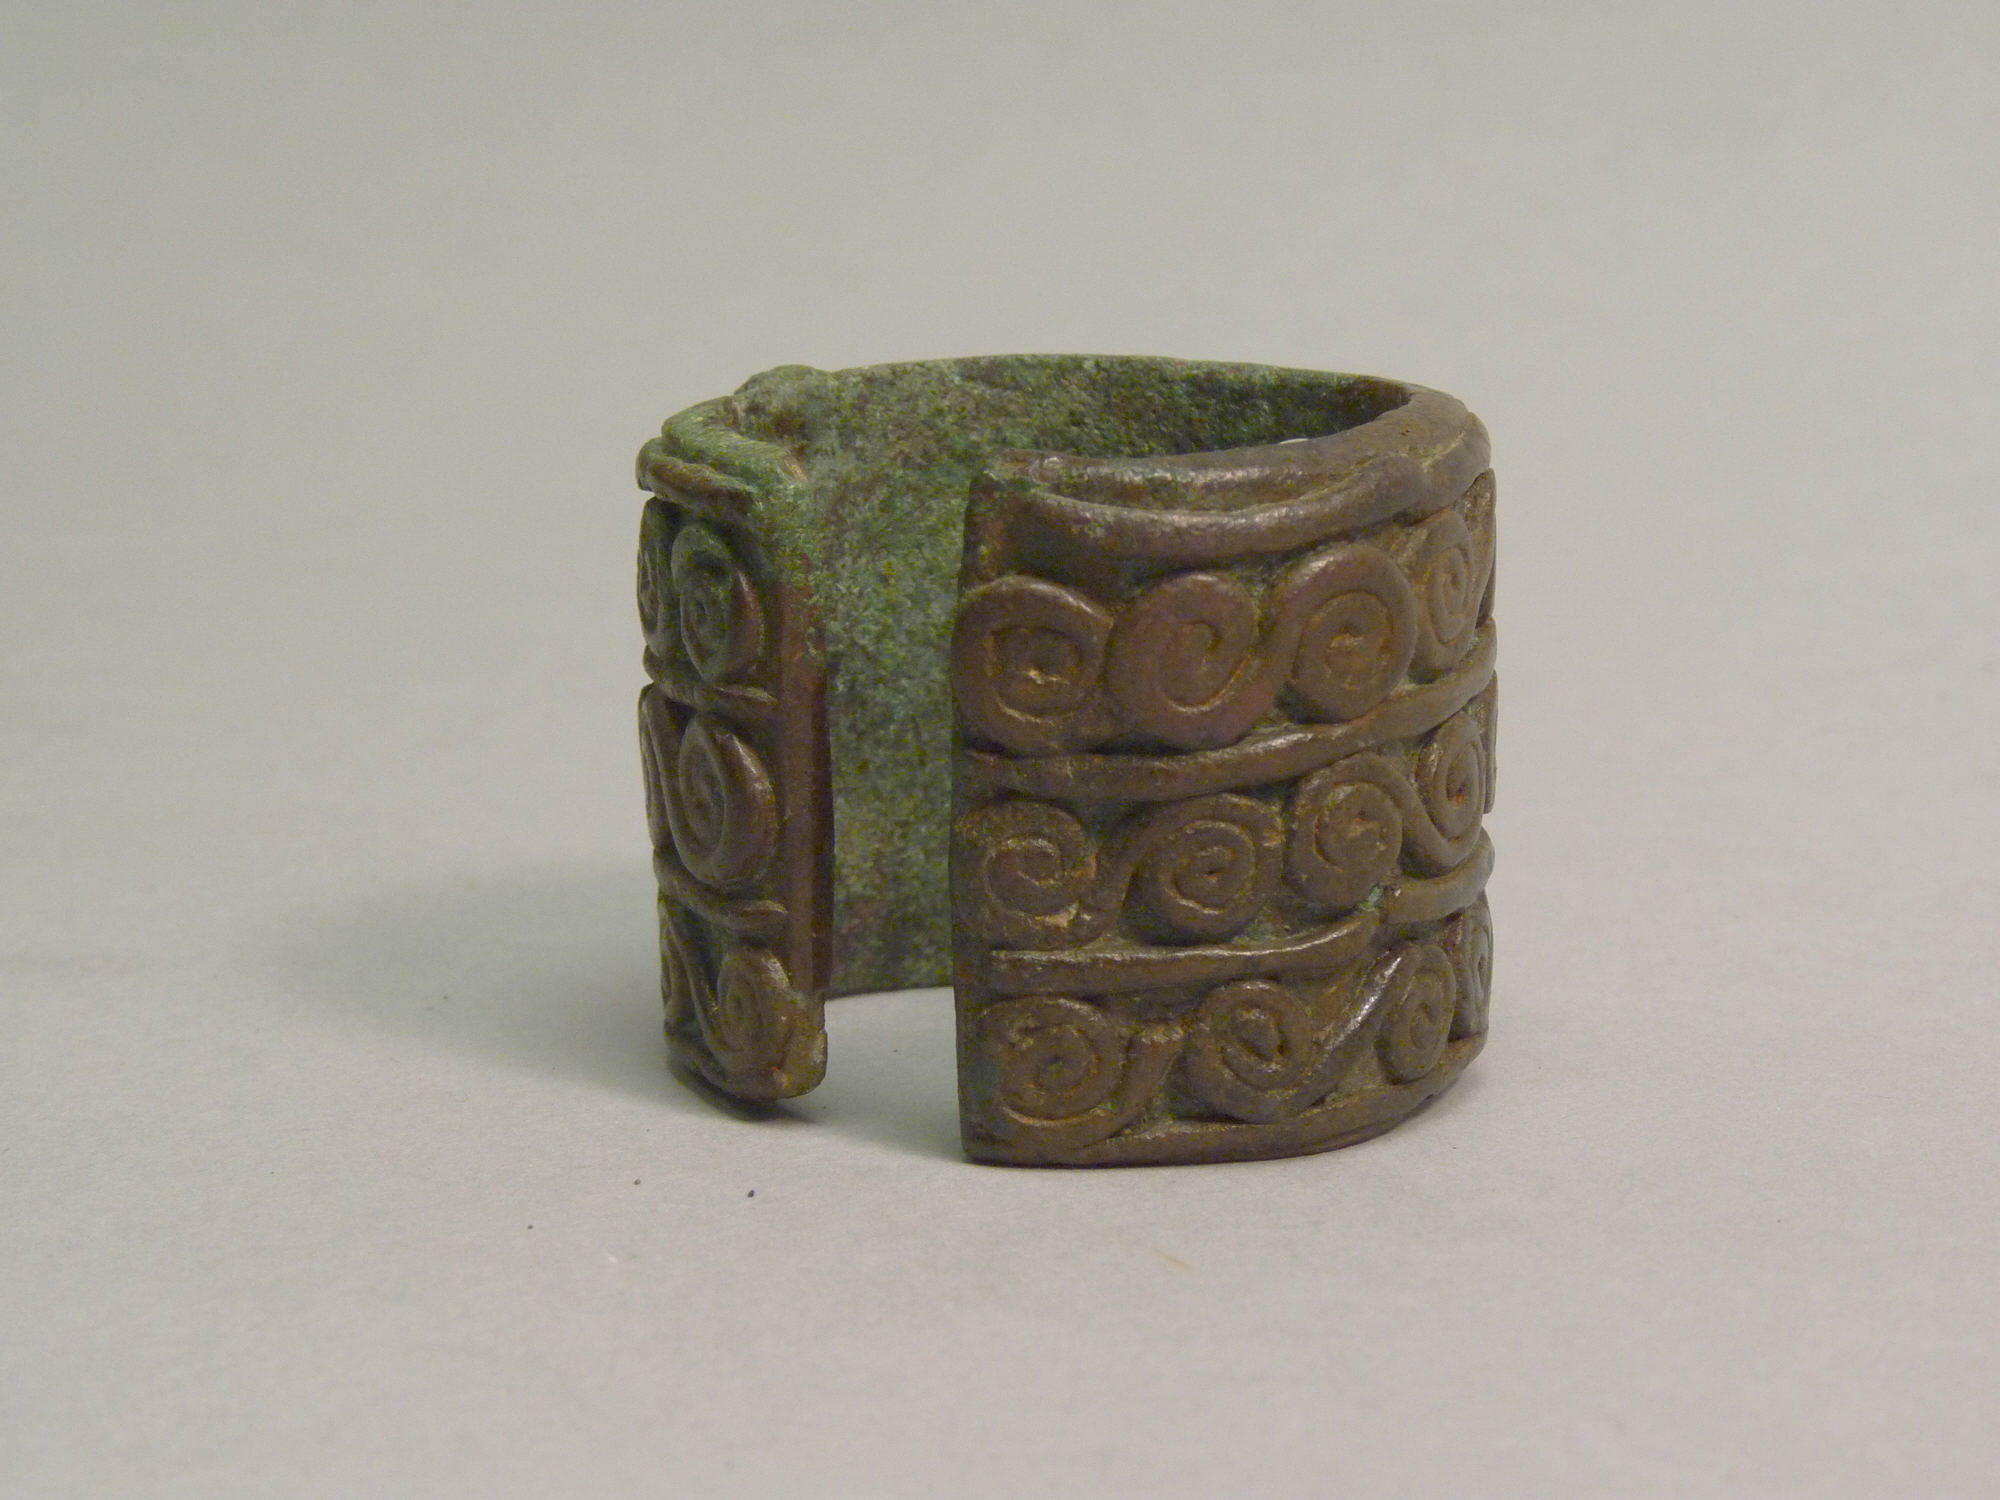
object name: cuff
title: Cuff with Three Rows of "S"-Shaped Designs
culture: vietnamese, north, highlands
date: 500 BCE-300 CE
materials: bronze